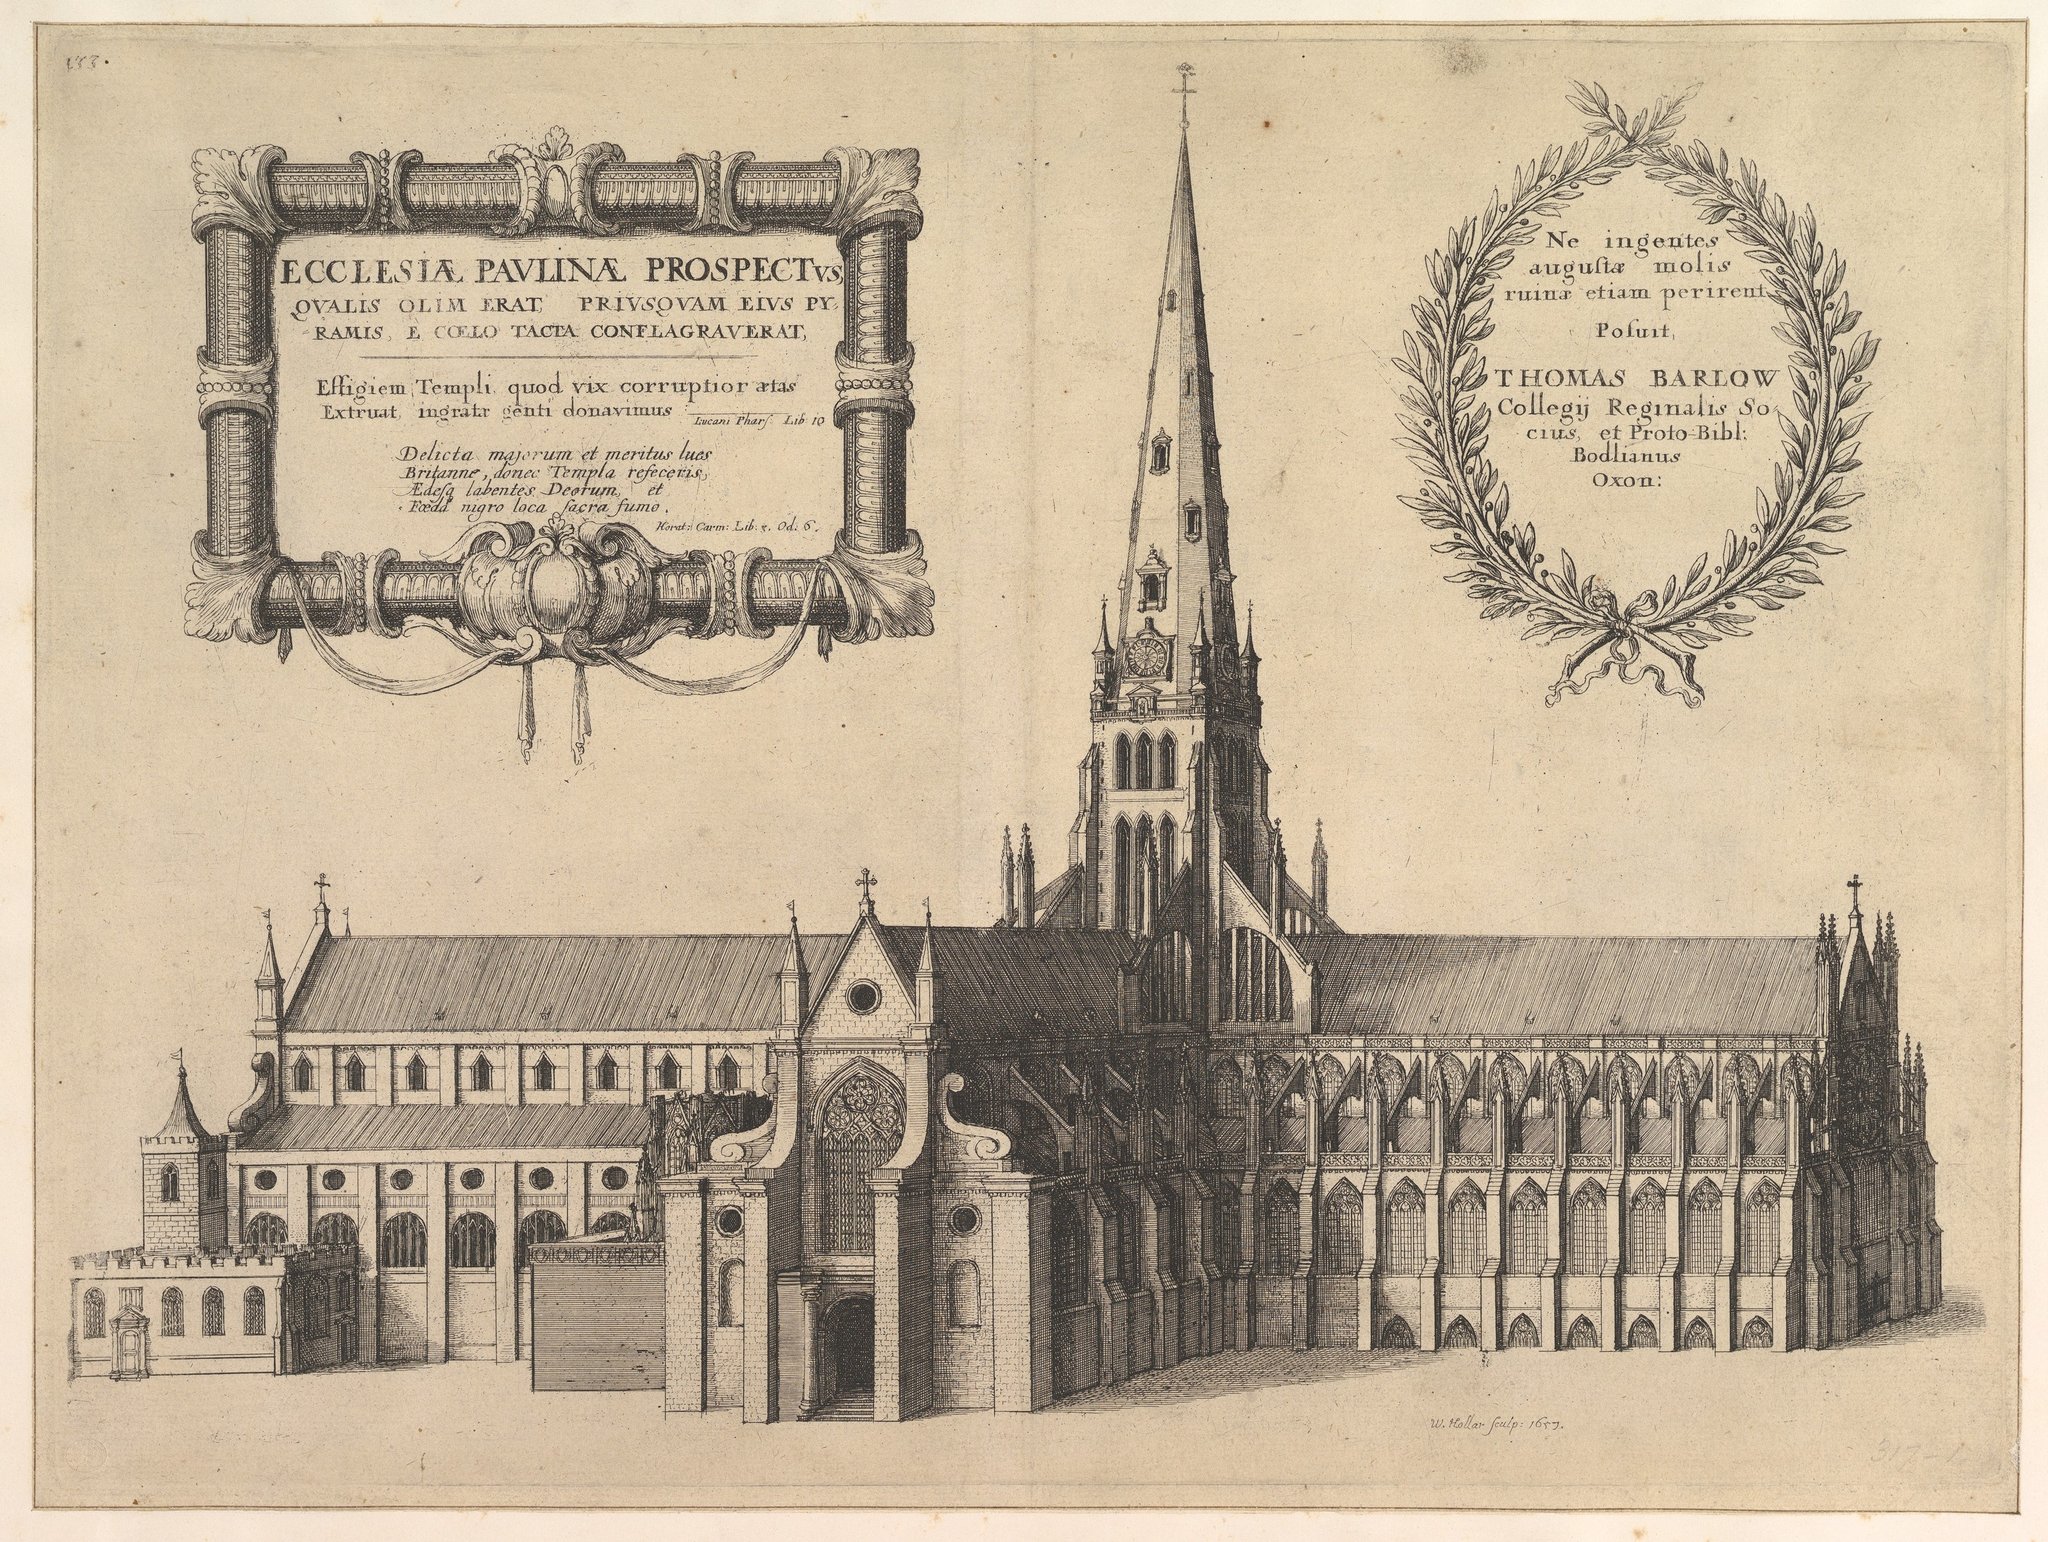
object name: print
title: Saint Paul's from the South Showing the Spire (Ecclesiae Paulinae Prospectus...), from "The History of St. Paul's Cathedral in London"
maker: wenceslaus hollar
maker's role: artist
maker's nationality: bohemian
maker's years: 1607-1677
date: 1657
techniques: etching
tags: churches,saint paul